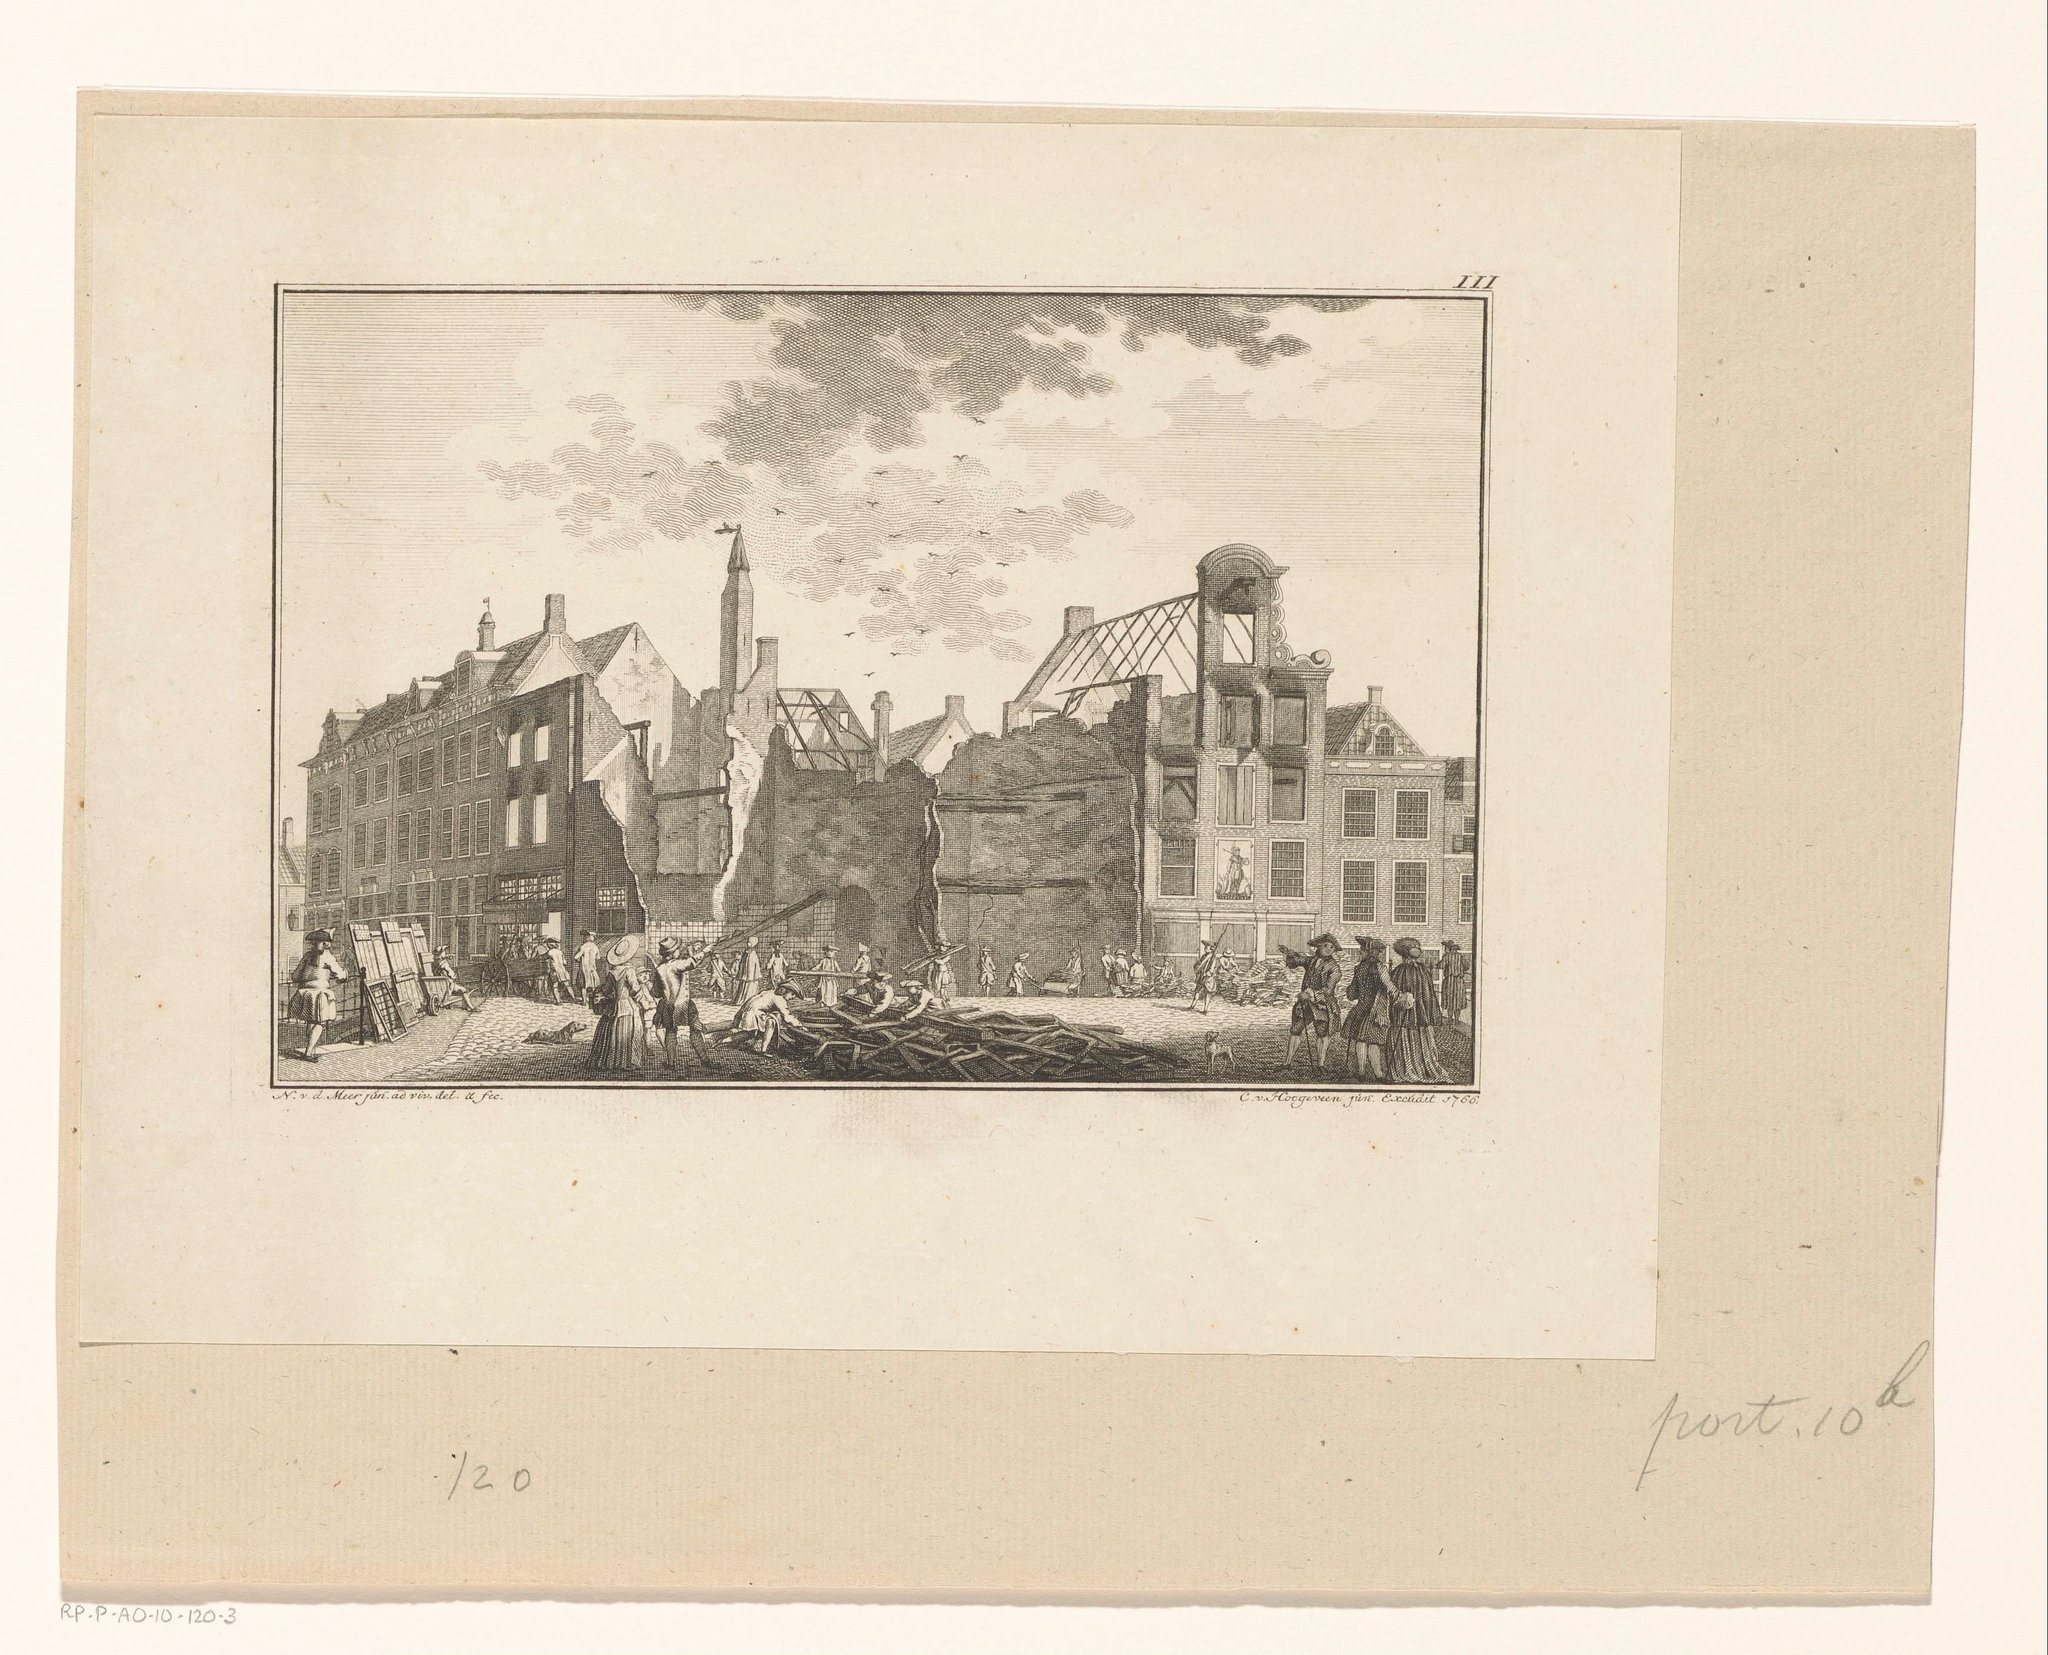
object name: print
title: Na de brand aan de Visbrug te Leiden, 1766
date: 1766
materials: paper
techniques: engraving, etching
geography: leiden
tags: ruin of a dwelling, house, castle, etc., leiden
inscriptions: collector's mark: Lugt 2228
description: Gezicht op de ruïnes van de gebouwen aan de Visbrug en Hoogstraat te Leiden na de brand van 3 oktober 1766. Het puin wordt geruimd en afgevoerd. Rechtsboven genummerd: III. Onderdeel van een serie van vijf platen over de brand van 1766 te Leiden.